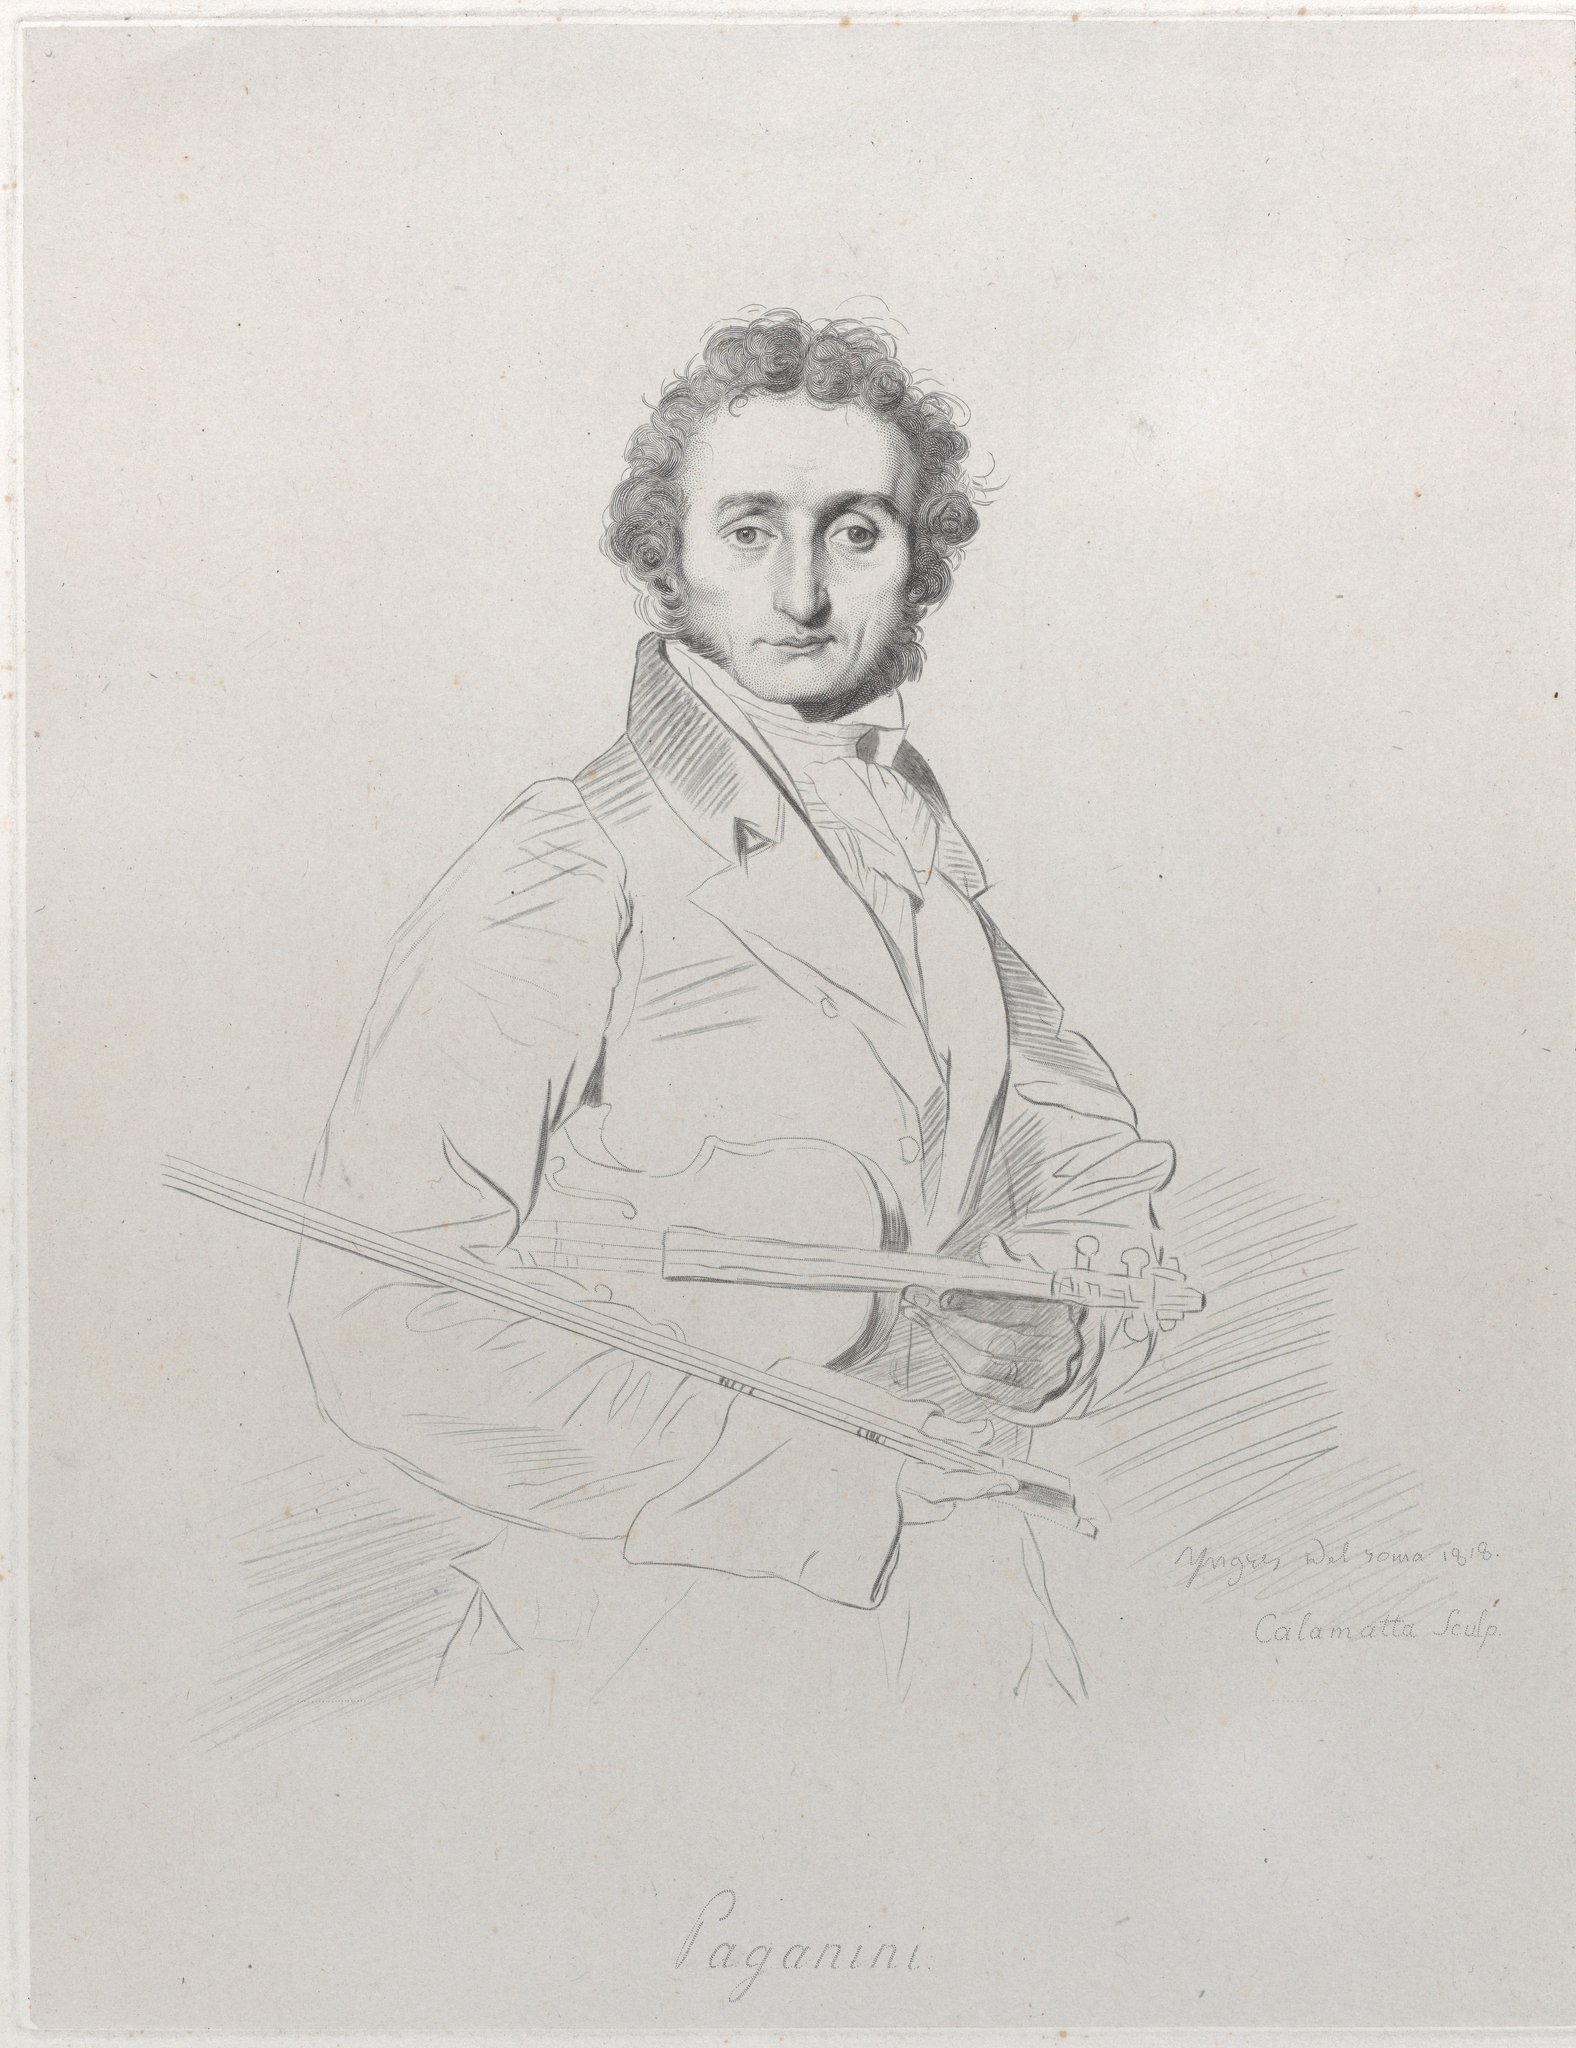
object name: print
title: Portrait of Niccolò Paganini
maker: luigi calamatta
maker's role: artist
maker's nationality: italian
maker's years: 1801-1869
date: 1830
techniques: printmaking, engraving, roulette, stippling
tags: men,portraits,violins,musicians